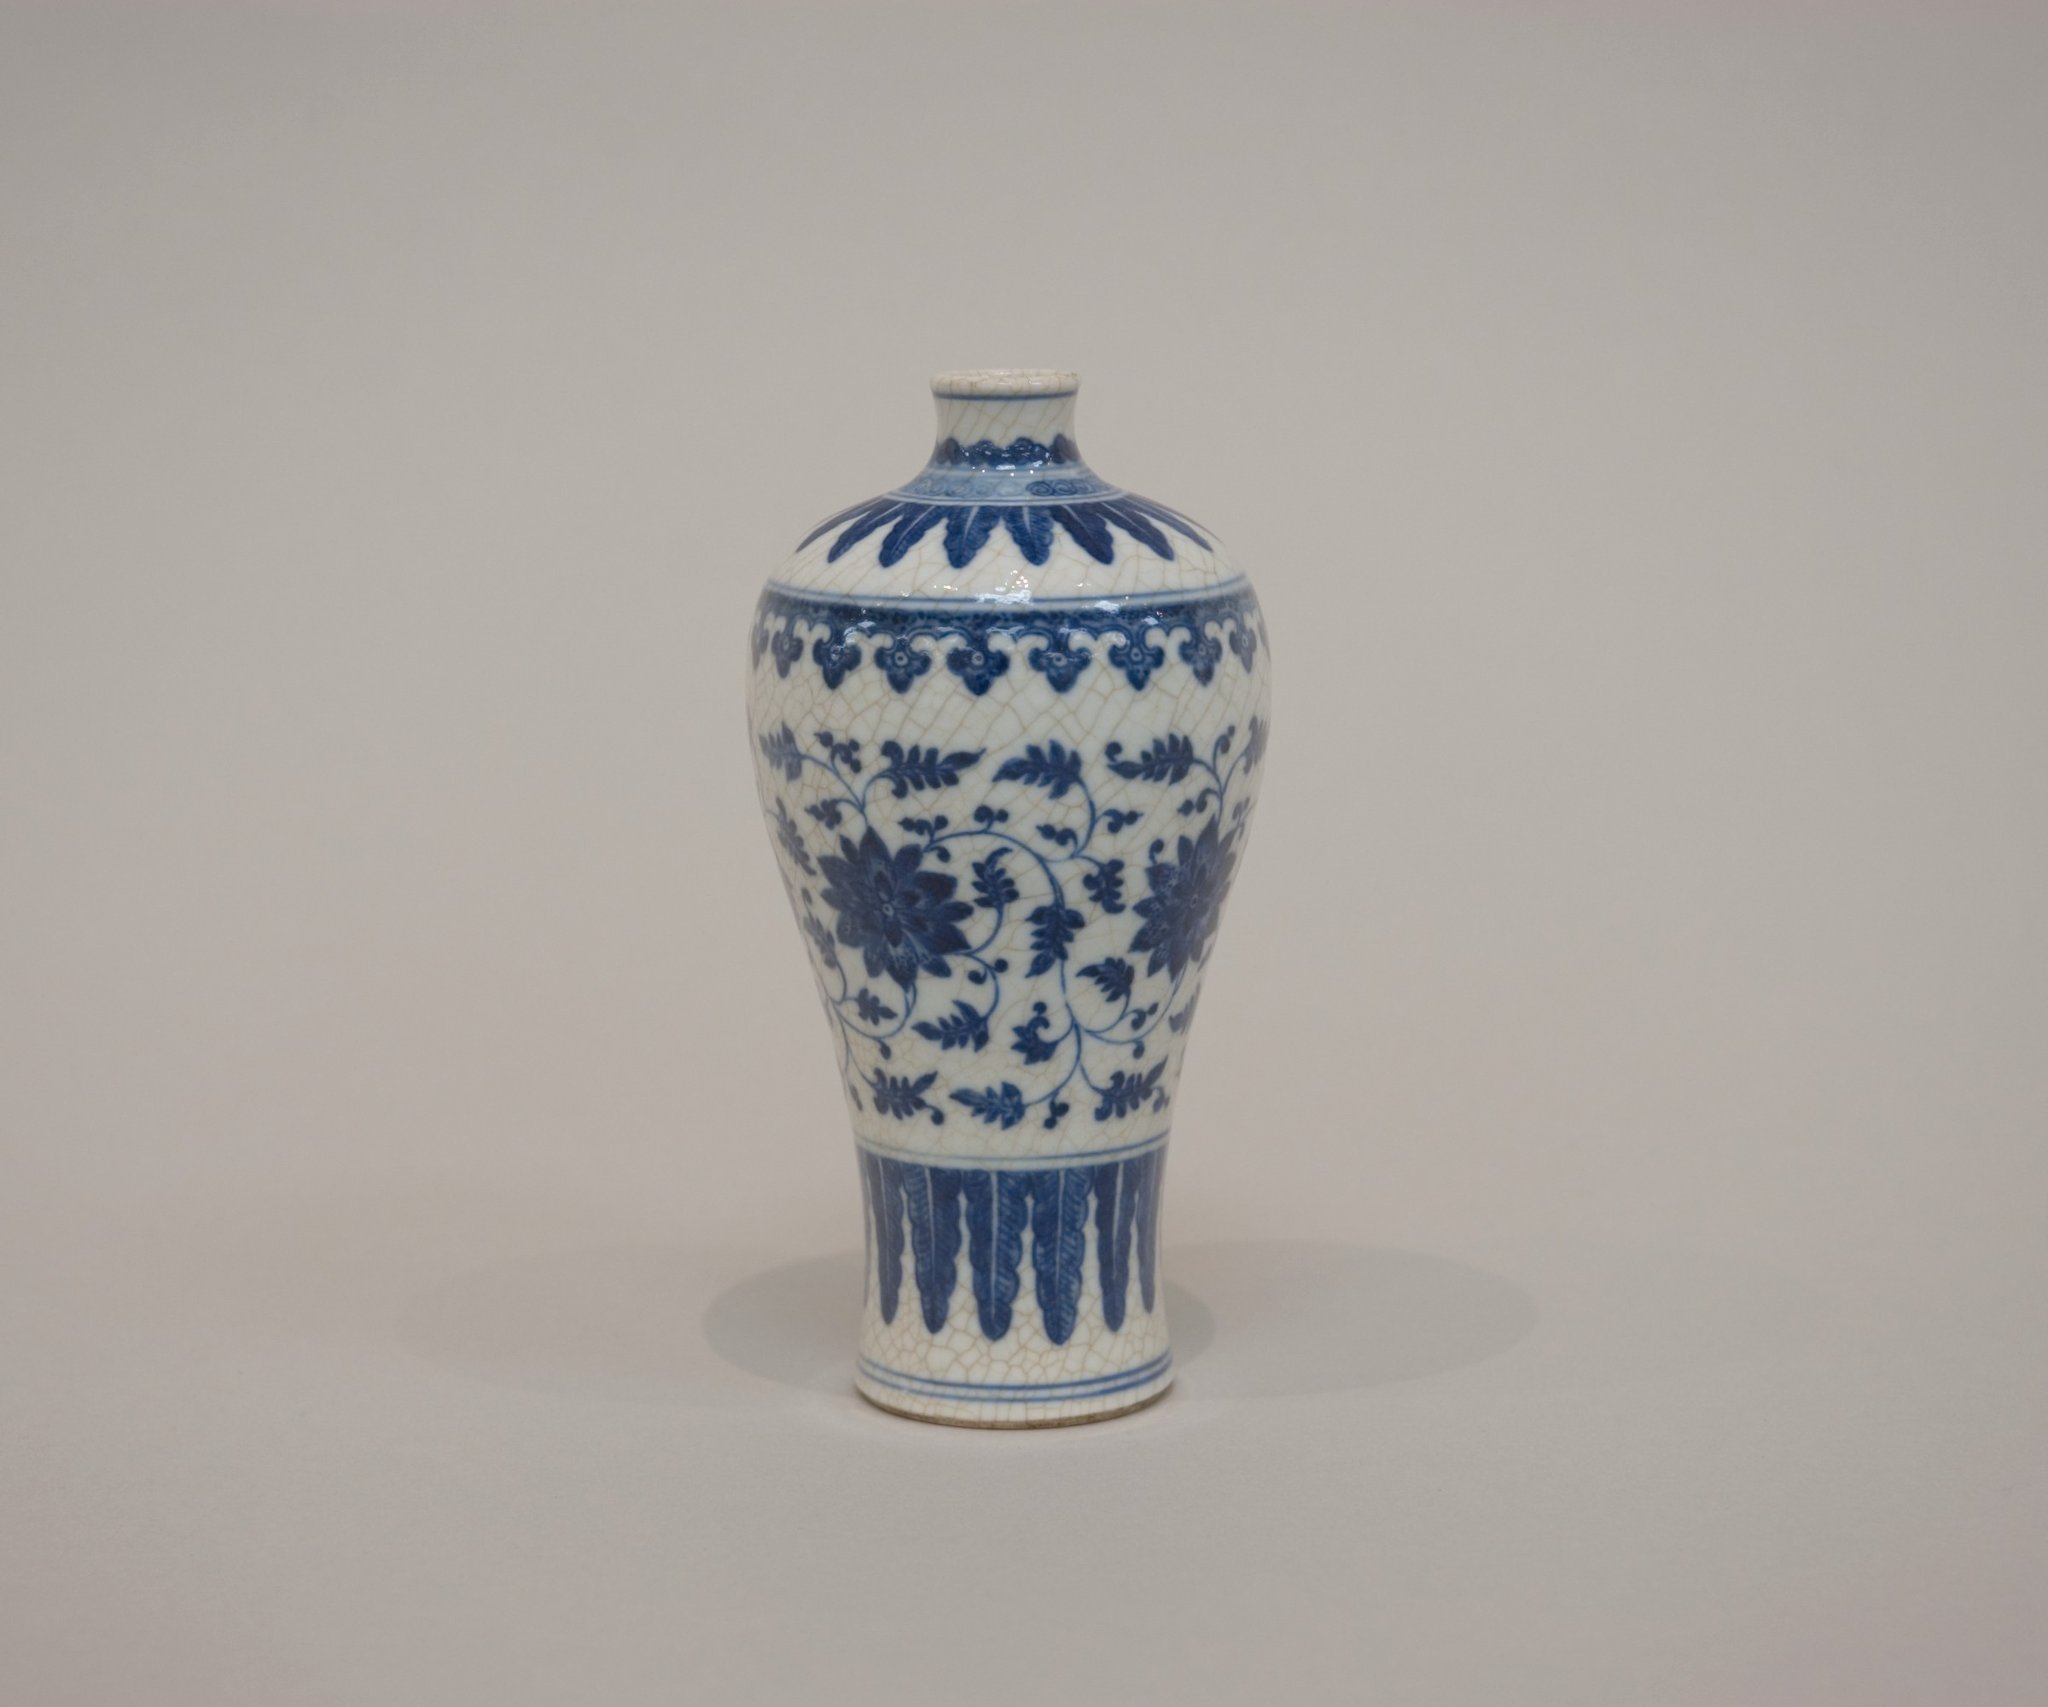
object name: vase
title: Meiping vase with floral scrolls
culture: chinese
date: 1667-1733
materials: cobalt, soft paste porcelain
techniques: painting, underglaze